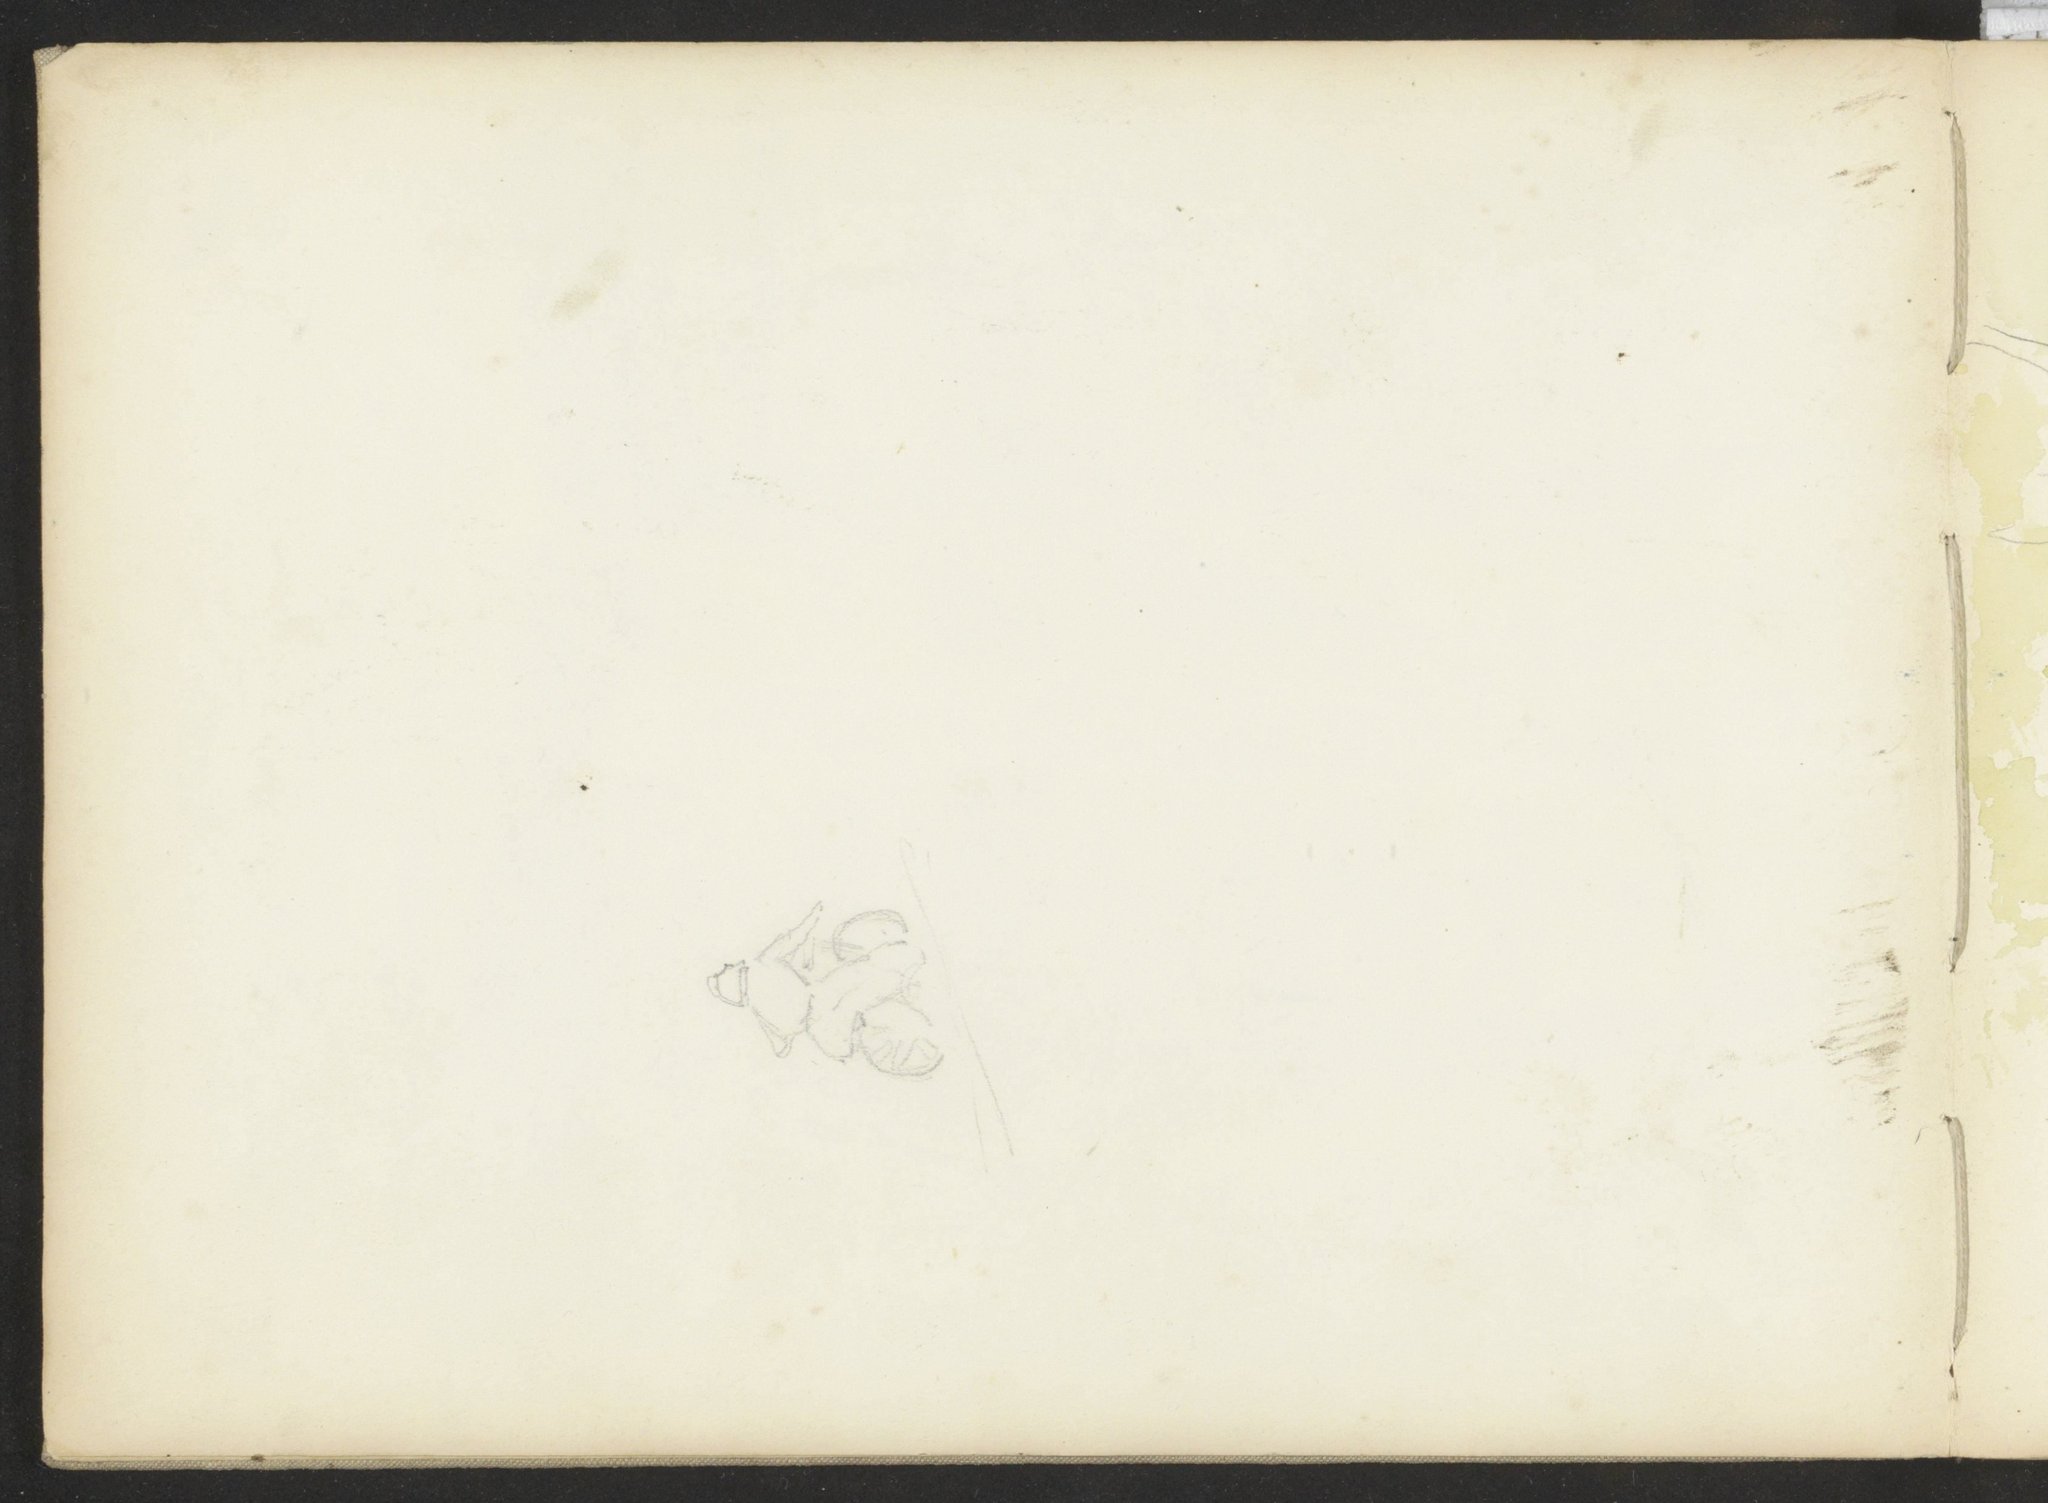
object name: sketchbook leaf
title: Fietser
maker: jonkheer johannes ludovicus paulus bosch van drakestein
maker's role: draughtsman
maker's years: 1865-1929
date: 1913-1916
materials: paper, pencil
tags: bicycle (+ one person ~ traffic and transport)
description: Blad 1 verso uit een schetsboek met 47 bladen.